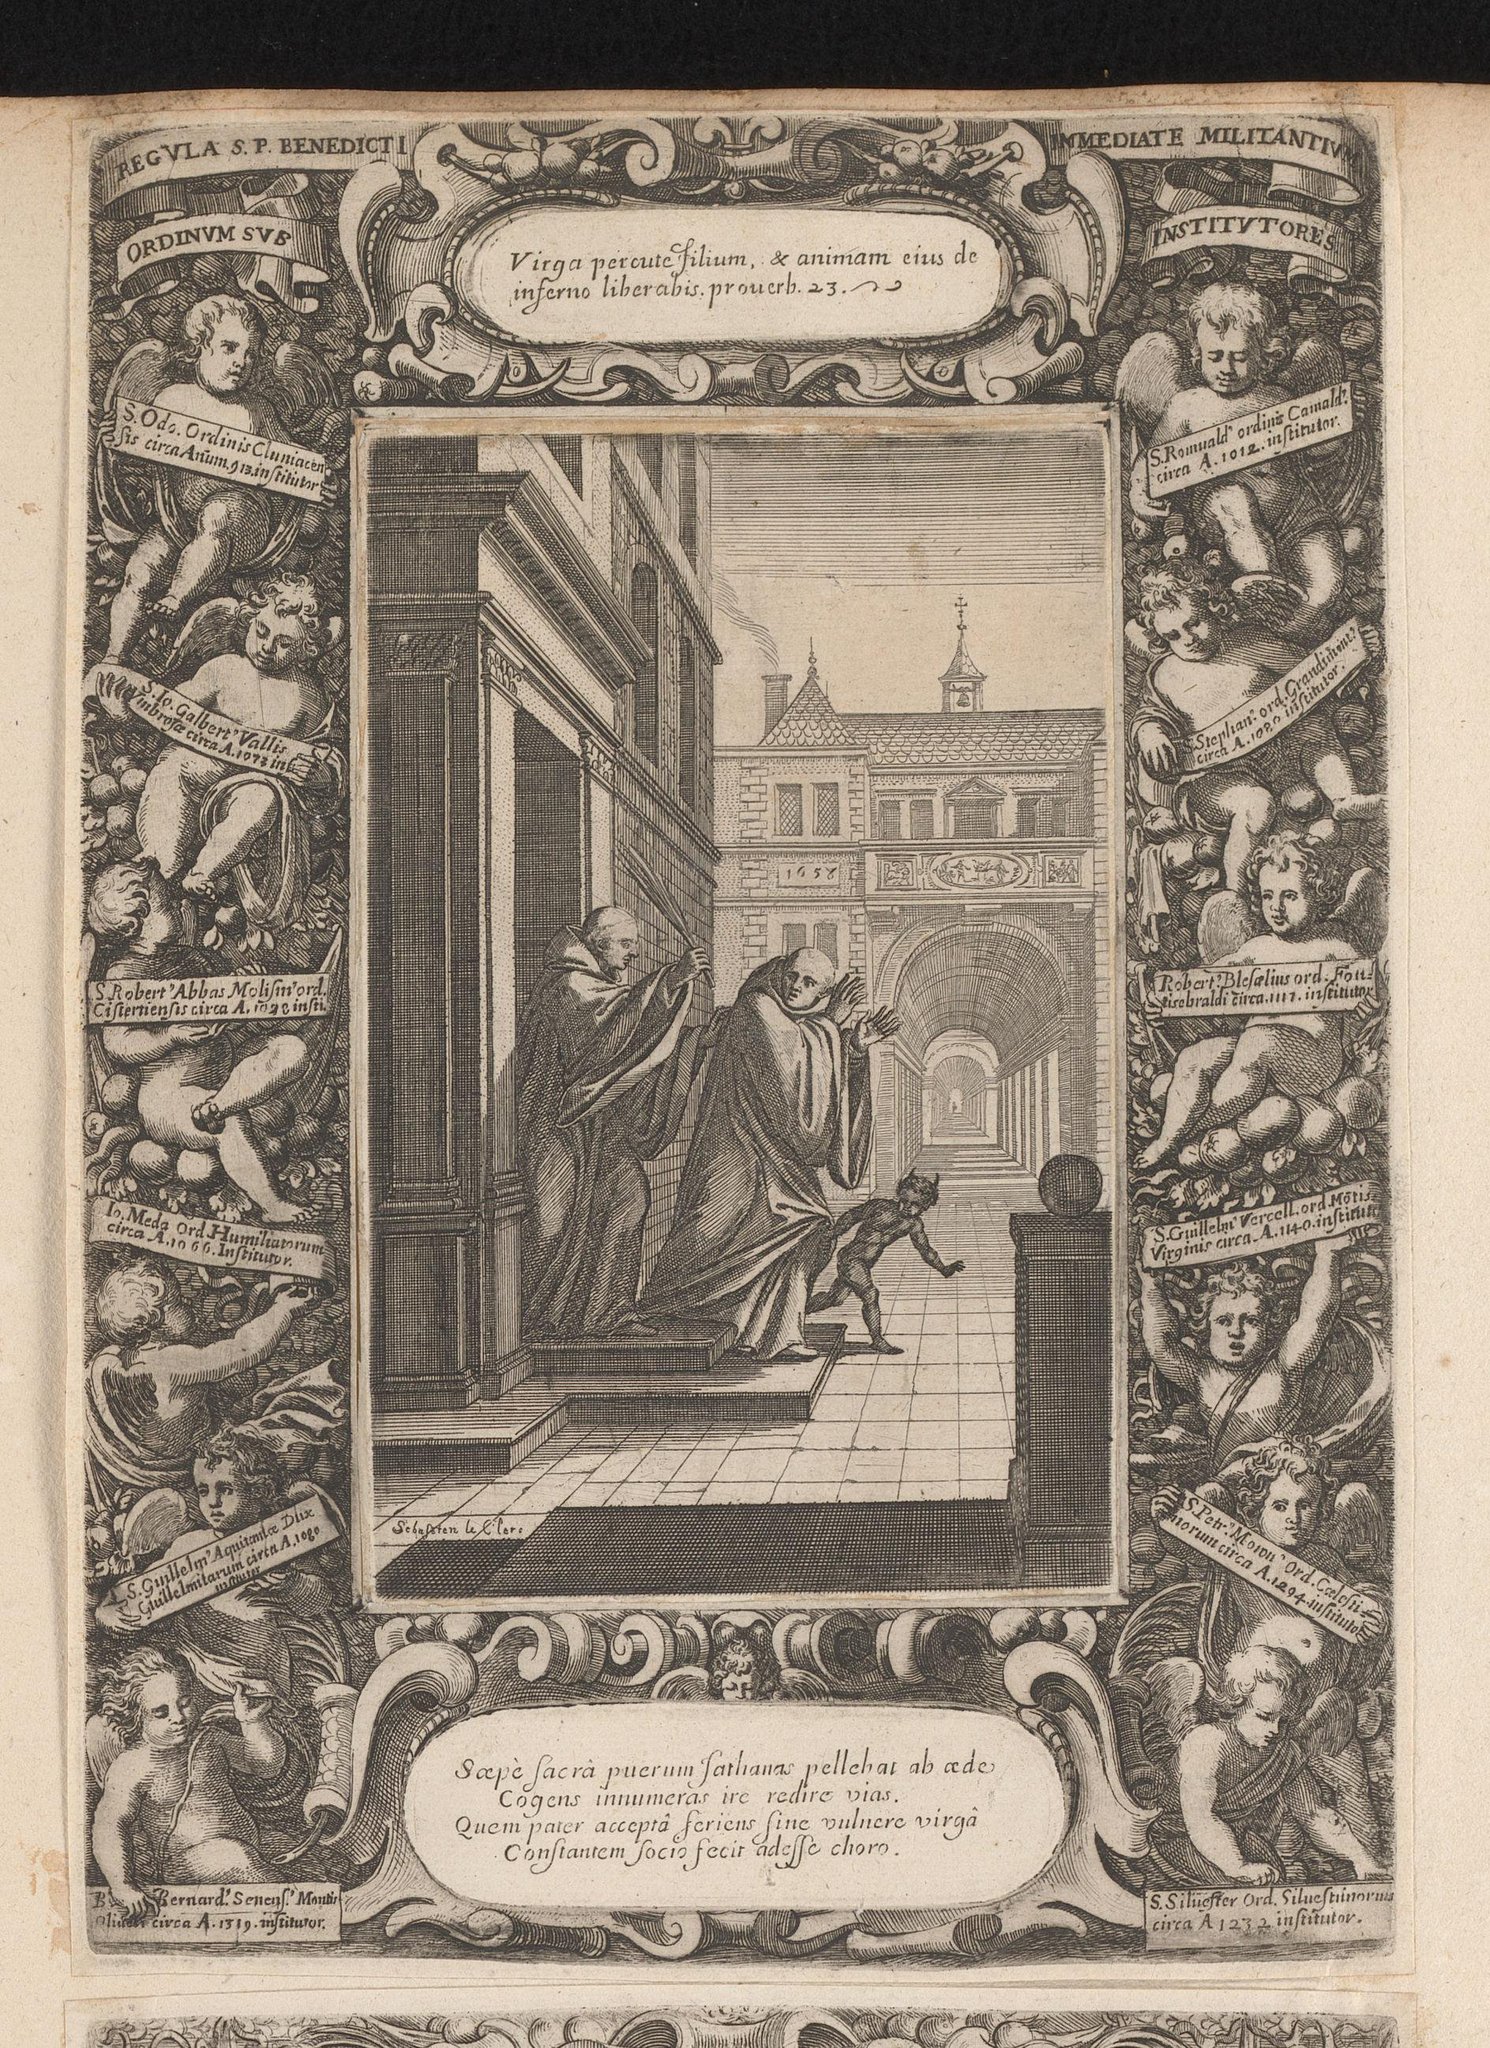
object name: album leaf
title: H. Benedictus corrigeert een door een duivel verleidde monnik, in een cartouche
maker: sébastien leclerc (i)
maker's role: print maker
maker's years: 1637-1714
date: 1658-1659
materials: paper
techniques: etching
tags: benedict of nurcia, abbot of monte cassino and founder of the benedictine order; possible attributes: aspergillum, book, cup (sometimes broken), raven with loaf, sieve (or tray)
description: Maakt deel uit van een serie bestaande uit 33 prenten met voorstellingen uit het leven van de Heilige Benedictus van Nursia in ornamentele cartouches, uitgegeven in 1658-1659. De prenten zijn gedrukt van drie afzonderlijke platen bestaande uit de voorstelling, de cartouche en de tekst.